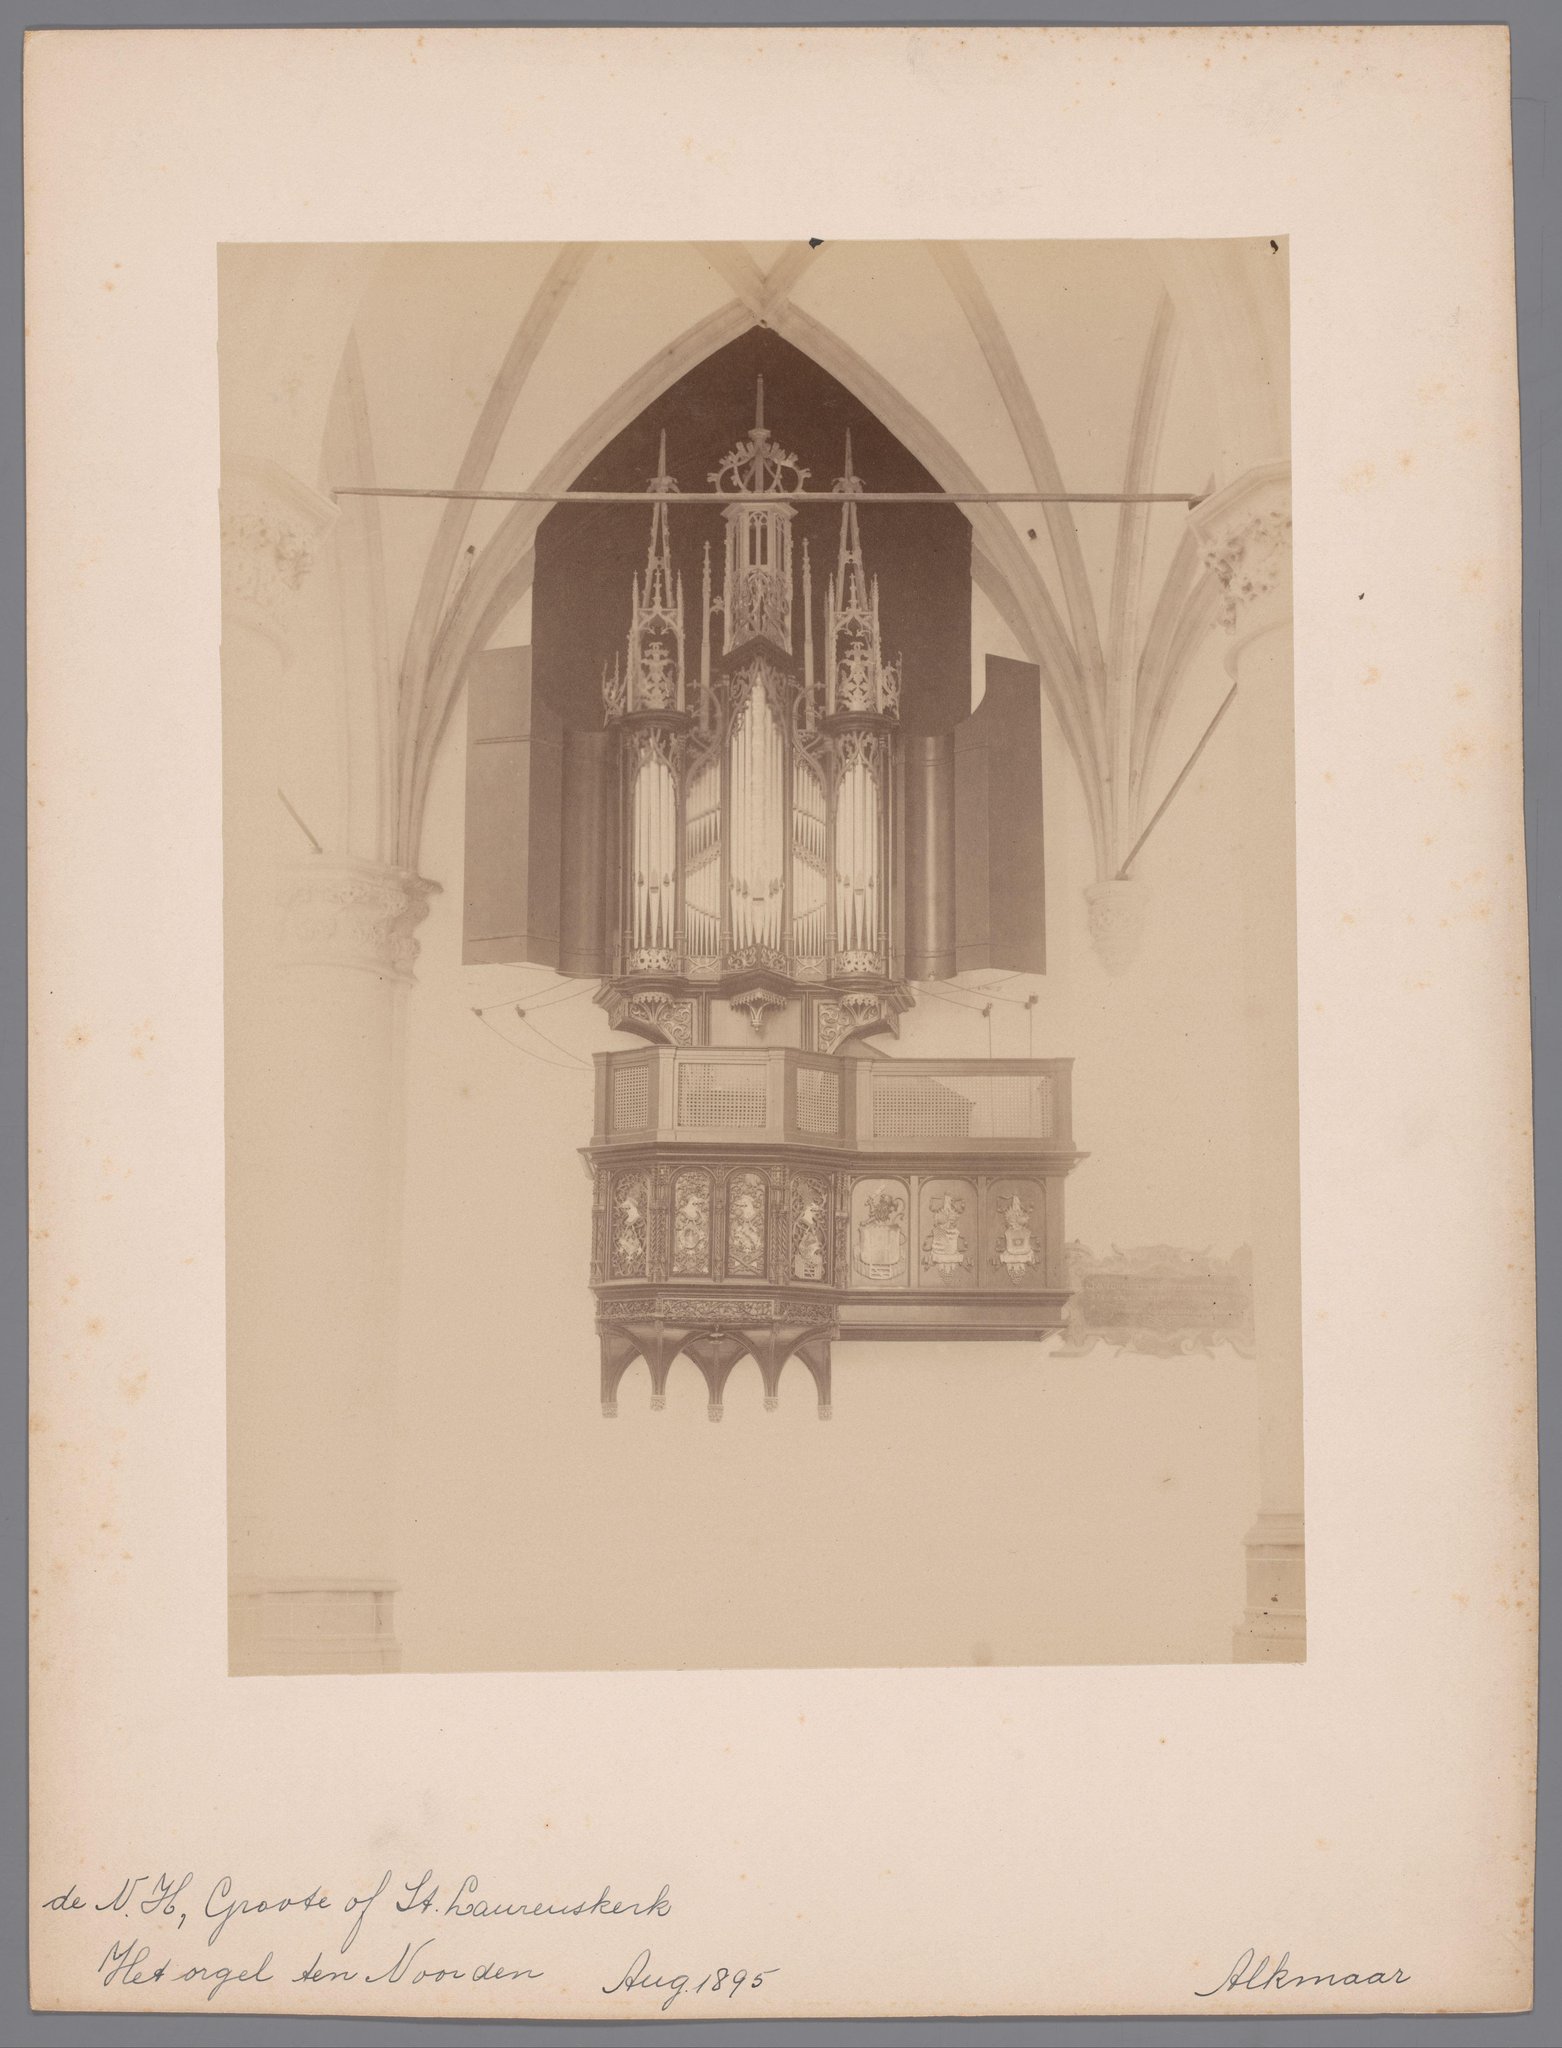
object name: photograph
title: Orgel aan de noordzijde van de Grote of Sint-Laurenskerk te Alkmaar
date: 1895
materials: cardboard, photographic support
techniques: albumen print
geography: grote of sint-laurenskerk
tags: church organ, interior of church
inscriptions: annotation: ‘Alkmaar (N.H.)/ Het orgel ten noorden/ v/h koor in de NH Kerk/ Aug 1895’, annotation: ‘de N.H, Groote of St. Laurenskerk/ Het orgel ten Noorden/ Aug. 1895/ Alkmaar’